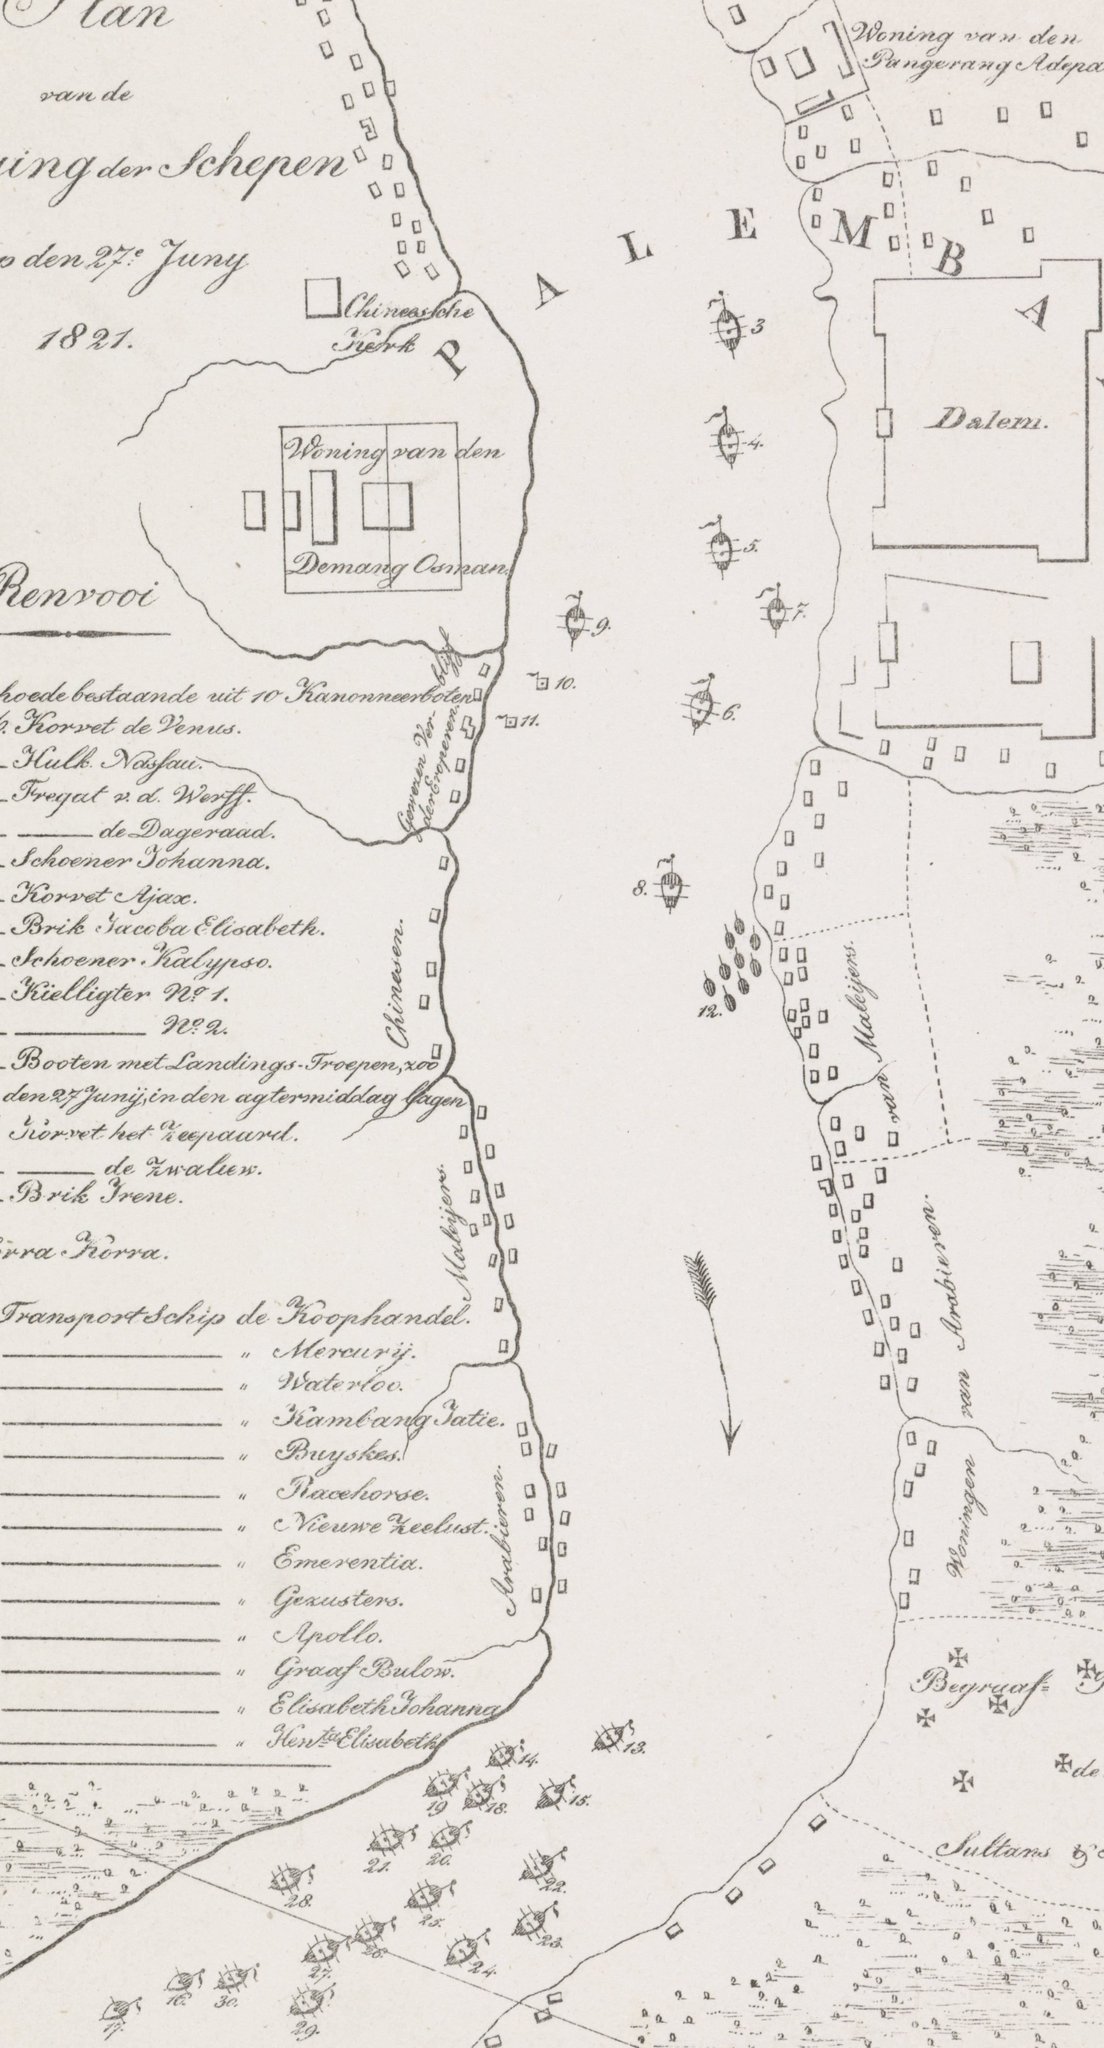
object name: map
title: Plan van de Ligging der Schepen op den 27e Juny 1821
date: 1821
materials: paper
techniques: lithograph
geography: amsterdam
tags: maps of separate countries or regions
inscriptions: collector's mark: Lugt 2228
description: Kaart van de rivier bij Palembang met de ligging van de Nederlandse schepen op 27 juni 1821 tijdens de Tweede expeditie naar Palembang op Sumatra. Links de legenda 1-30. Zie ook de pendant.